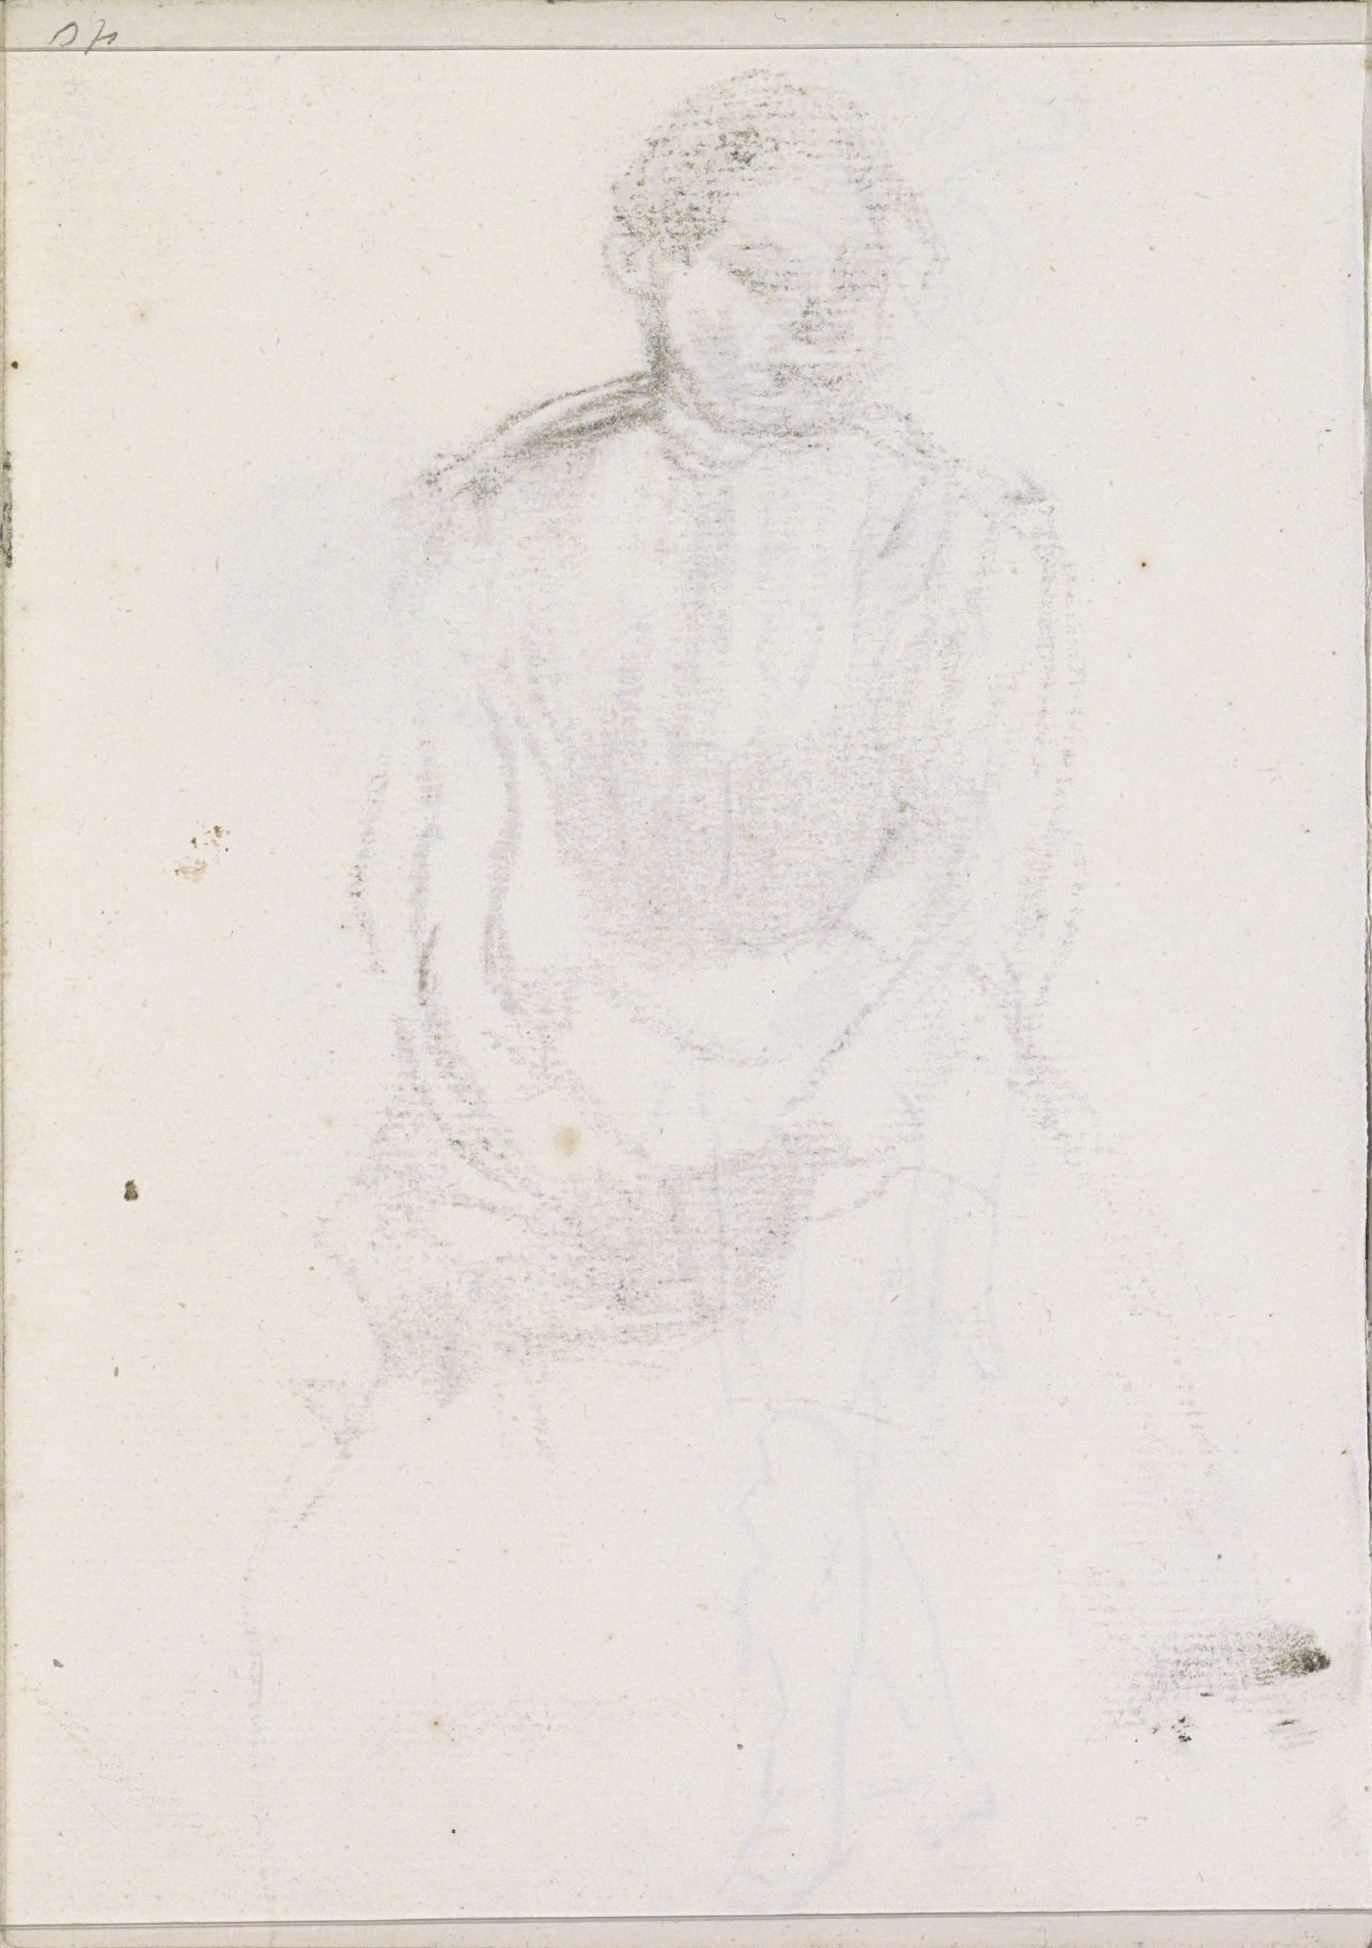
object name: sketchbook leaf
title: Abklatsch van de krijttekening op blad 4 recto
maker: isaac israels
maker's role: draughtsman, painter, print maker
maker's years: 1865-1934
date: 1886-1934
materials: paper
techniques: printmaking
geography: amsterdam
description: Blad 3 verso uit schetsboek LV met 21 bladen.